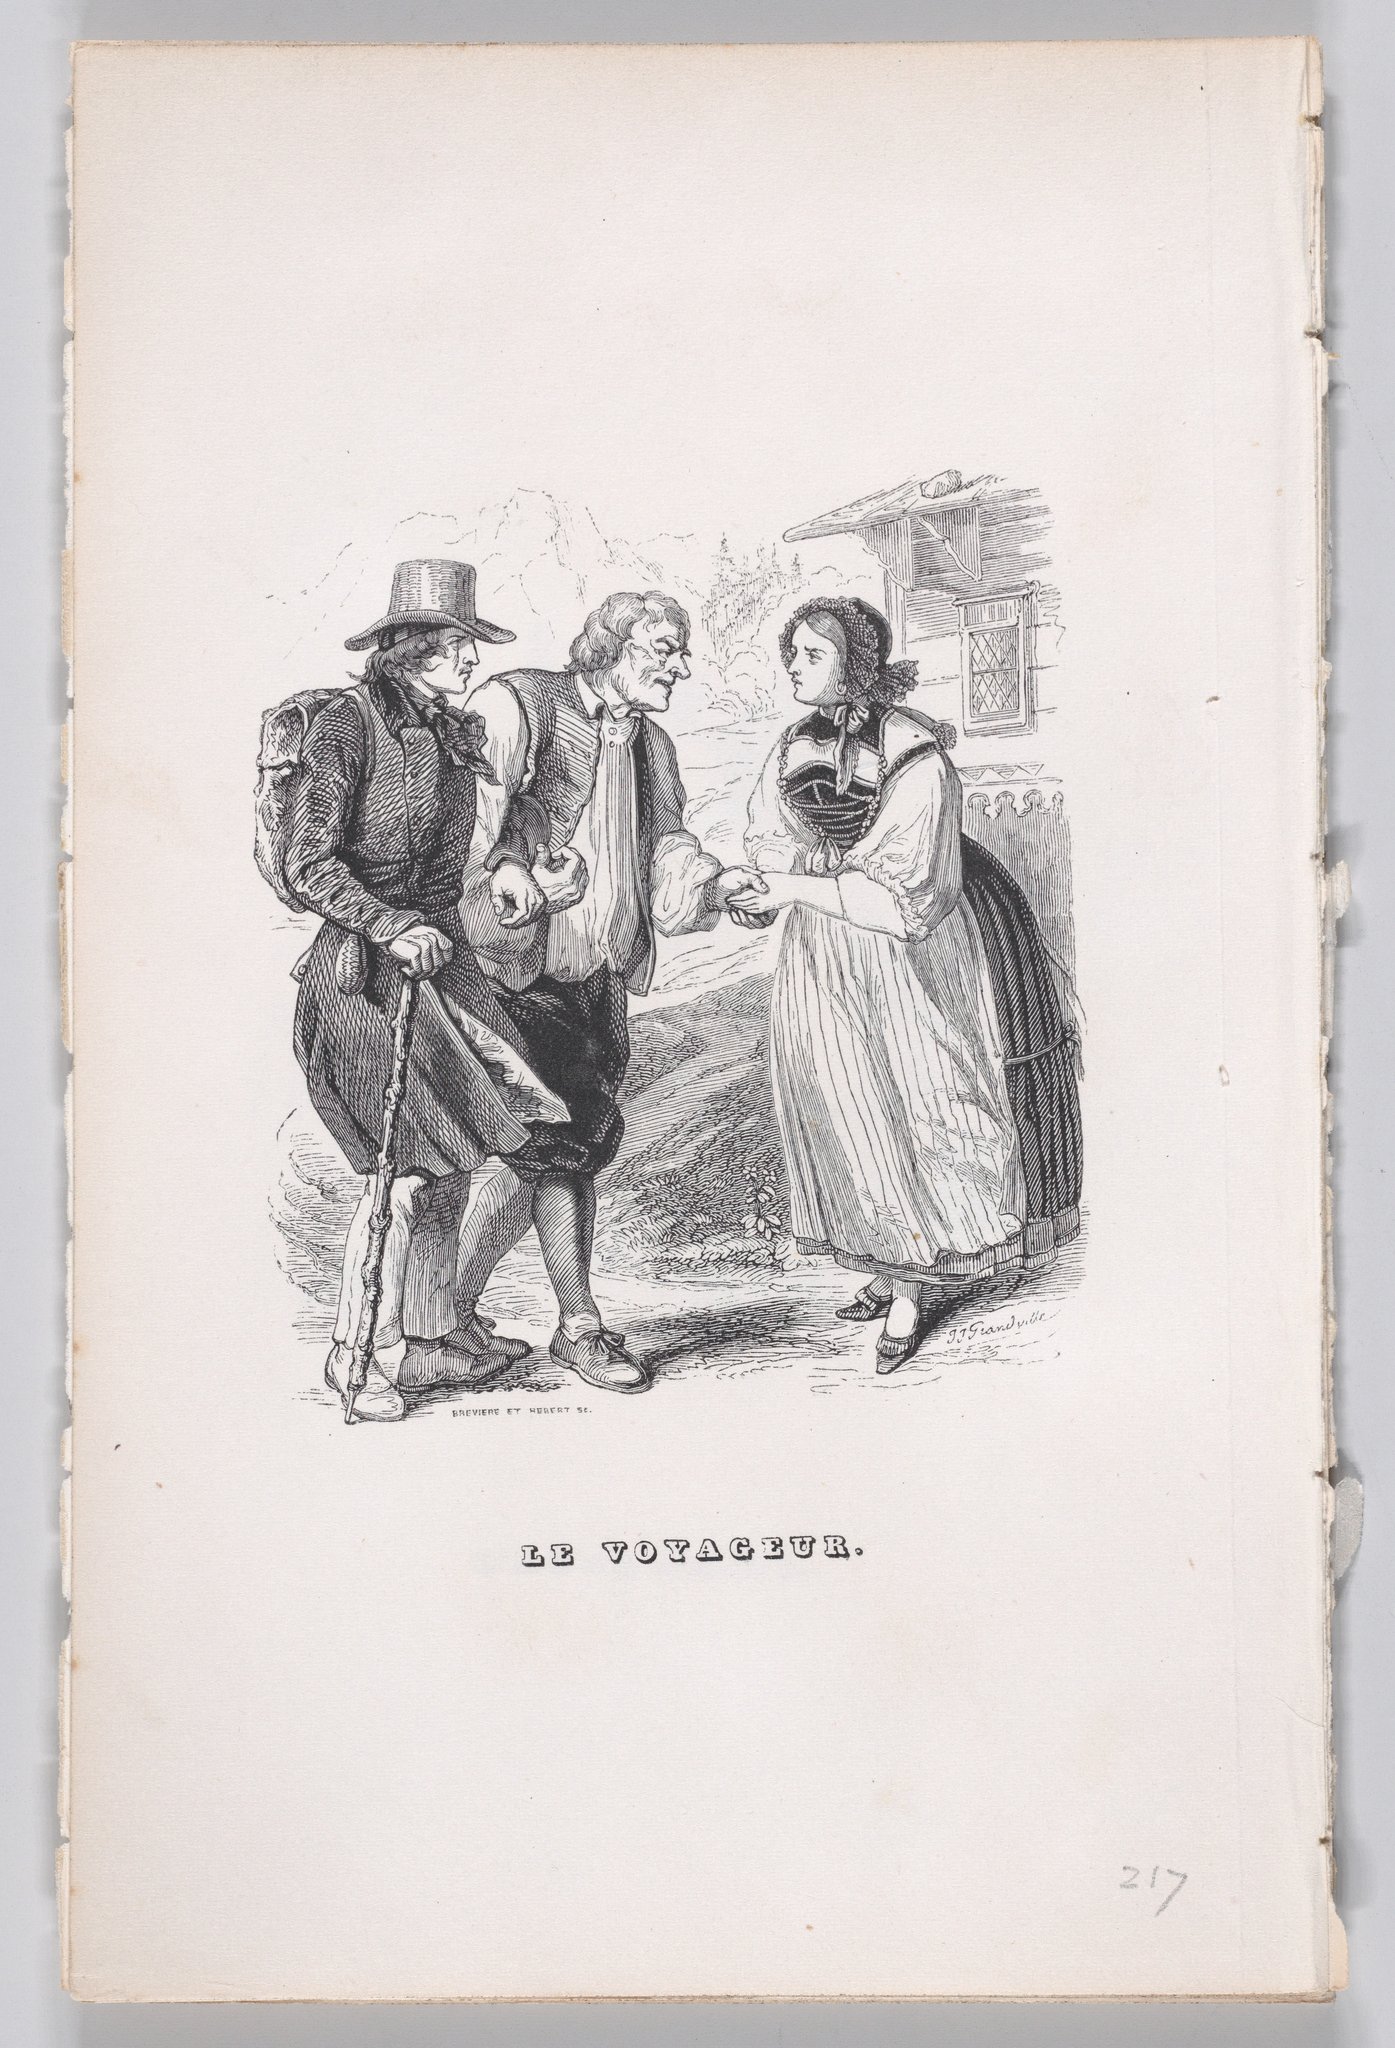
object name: print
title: The Traveler, from "The Complete Works of Béranger"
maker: j. j. grandville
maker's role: illustrator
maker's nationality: french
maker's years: 1803-1847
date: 1836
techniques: engraving